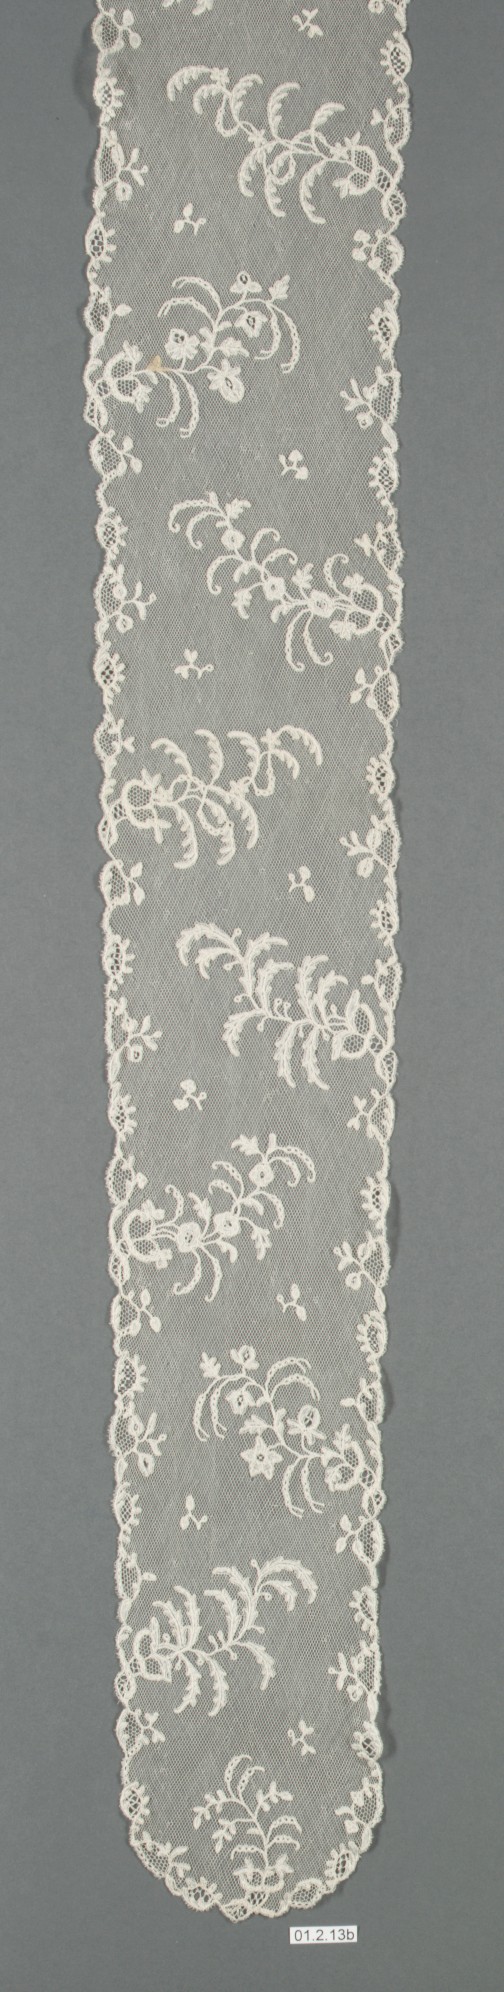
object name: lappet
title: Pair of lappets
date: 1701-1800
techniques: lace